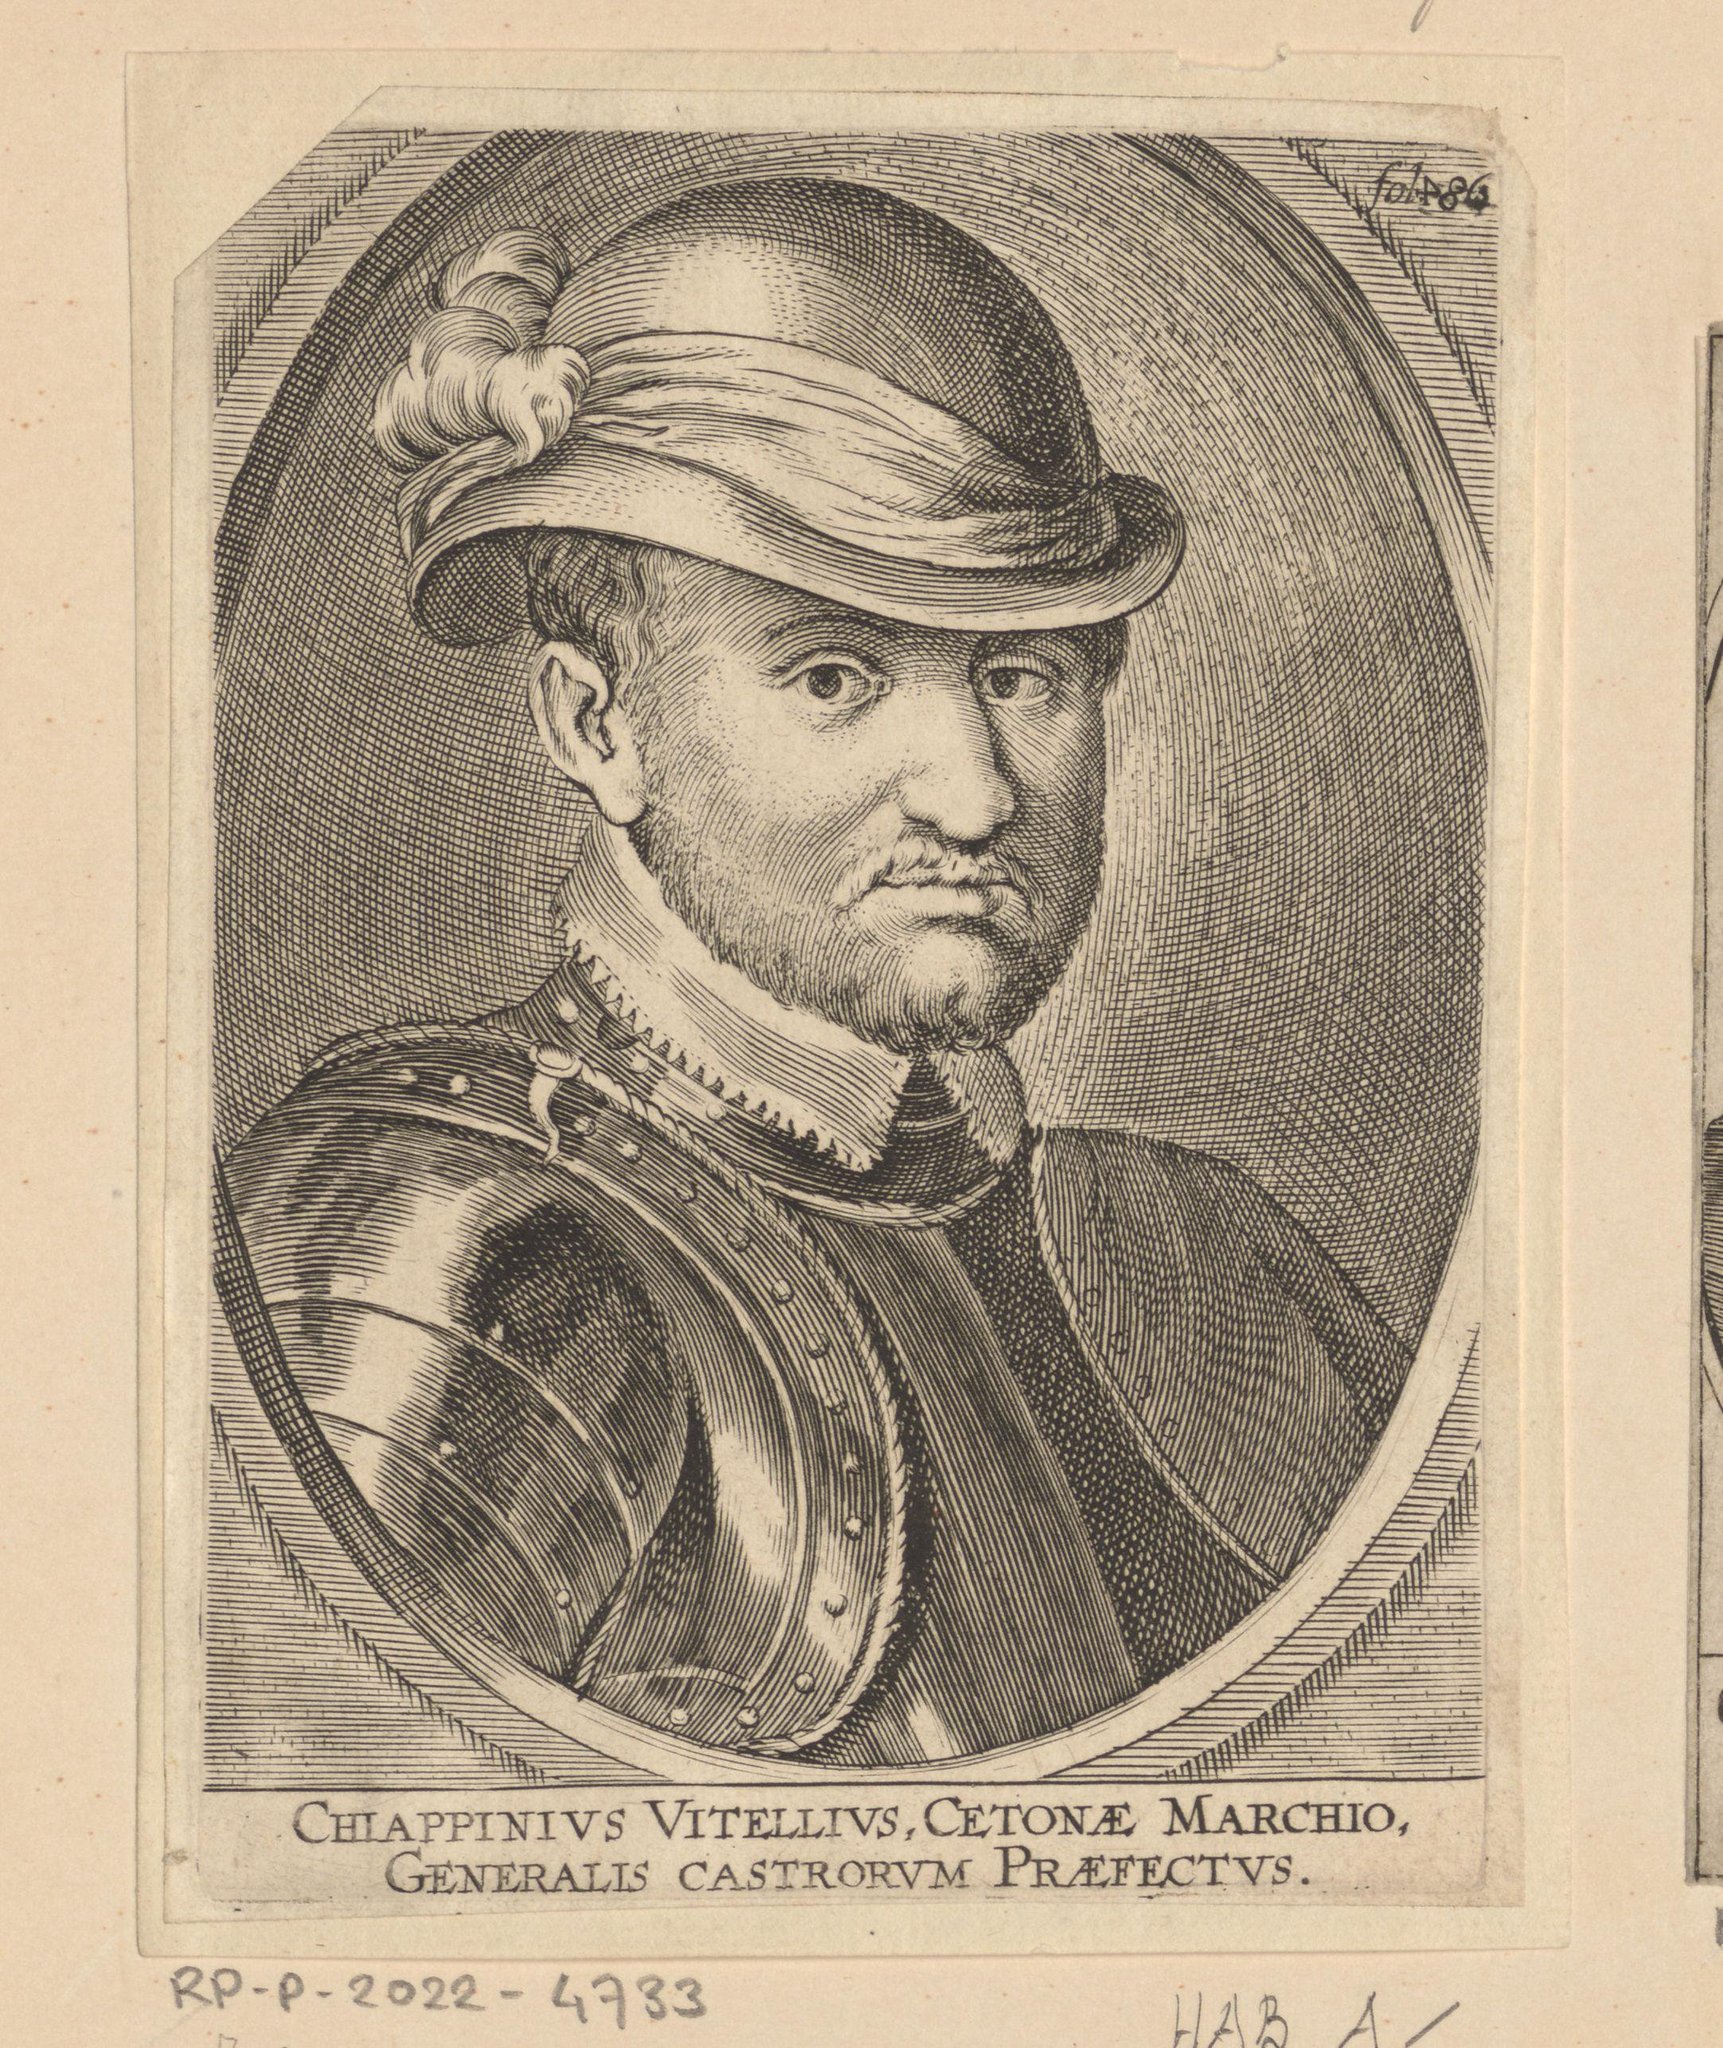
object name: book illustration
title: Portret van Giovan Luigi Vitelli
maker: jacob neefs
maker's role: print maker, publisher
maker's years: 1610-1660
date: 1640-1750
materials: paper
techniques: engraving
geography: antwerp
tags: commander-in-chief, general, marshal, historical persons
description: Prent waarschijnlijk uit een van de delen en/of vertalingen van: Strada, Famiano. De bello Belgico. Uitgegeven tussen 1632-1750. Portret voor het eerst uitgegeven met omlijsting in: Strada, Famiano. De Bello Belgico. Antwerpen: Jan Cnobbaert, 1640, dl. 1. Andere staat met afwijkende omlijsting komt voor in: Strada, Famiano. De thien eerste boecken der Neder-landtsche oorloghe. Antwerpen: weduwe en erfgenamen Jan Cnobbaert, 1645. Het is onduidelijk op welk moment deze staat is uitgegeven.